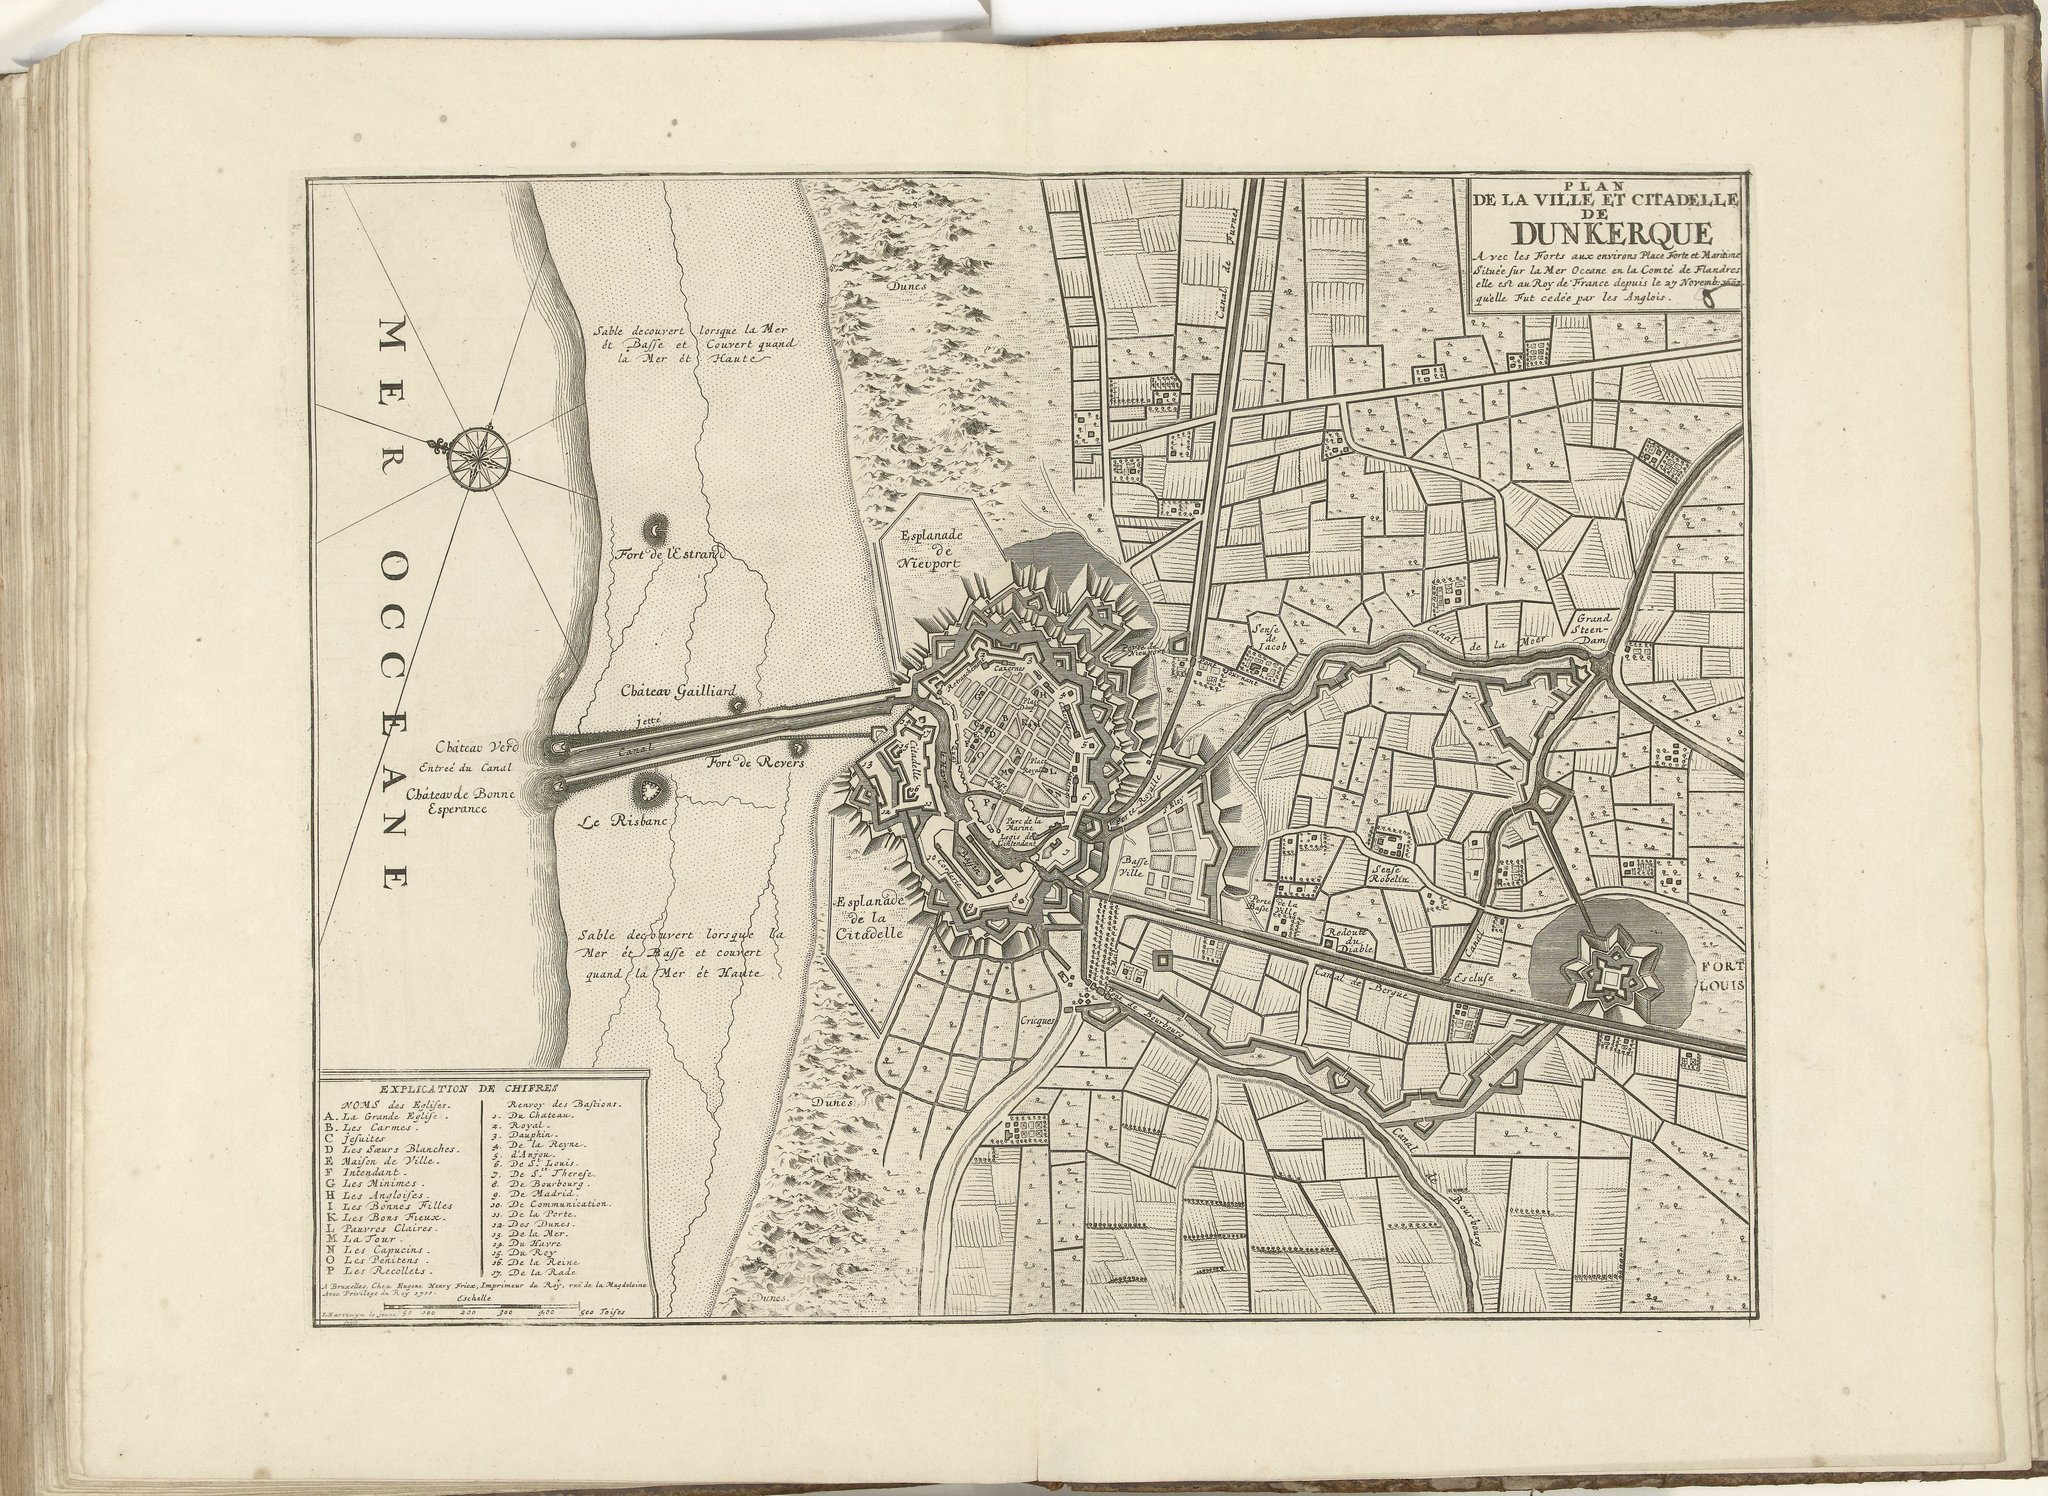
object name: print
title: Plattegrond van Duinkerke, 1711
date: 1711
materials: paper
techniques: etching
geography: brussels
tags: maps of cities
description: Plattegrond van Duinkerke, 1711. Linksonder de legenda A-P en 1-17. Onderdeel van een gebundelde verzameling van plannen van veldslagen en steden vermaard in de Spaanse Successieoorlog.